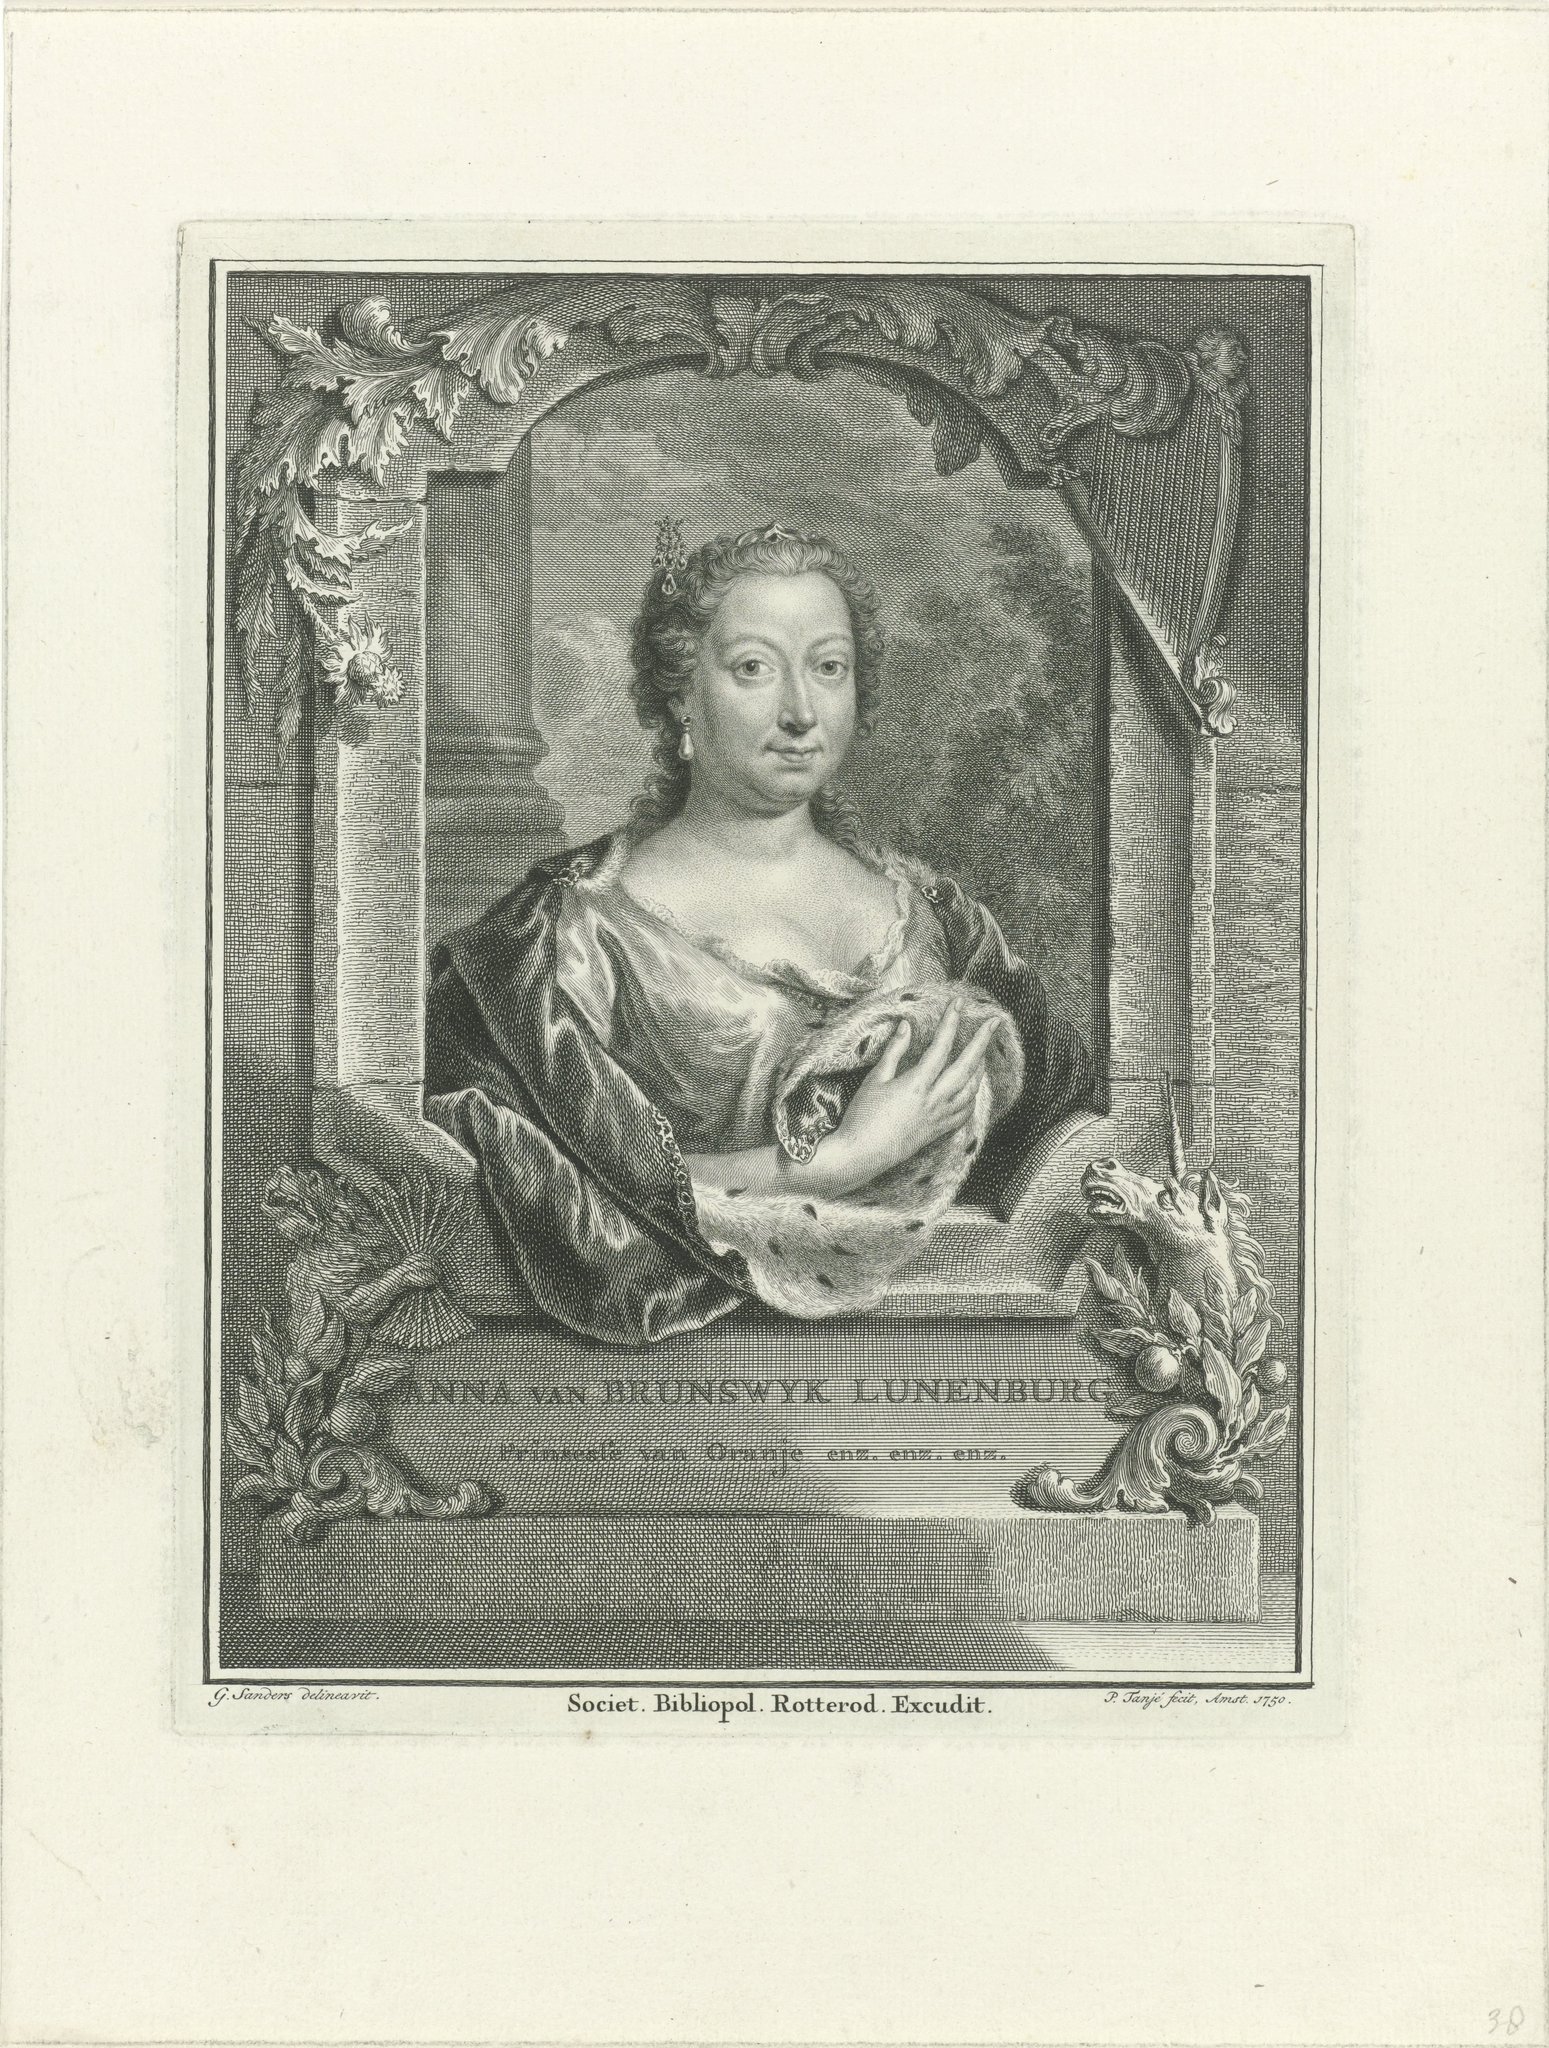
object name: print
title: Portret van Anna van Hannover, prinses van Oranje-Nassau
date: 1750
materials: paper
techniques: engraving, etching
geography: amsterdam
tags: the hague, anna van hannover, unicorn, harp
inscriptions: collector's mark: Lugt 240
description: Portret van Anna van Hannover, prinses van Oranje-Nassau, omgeven door een ornamenteel kader. Linksonder de Hollandse leeuw, rechtonder een eenhoorn.